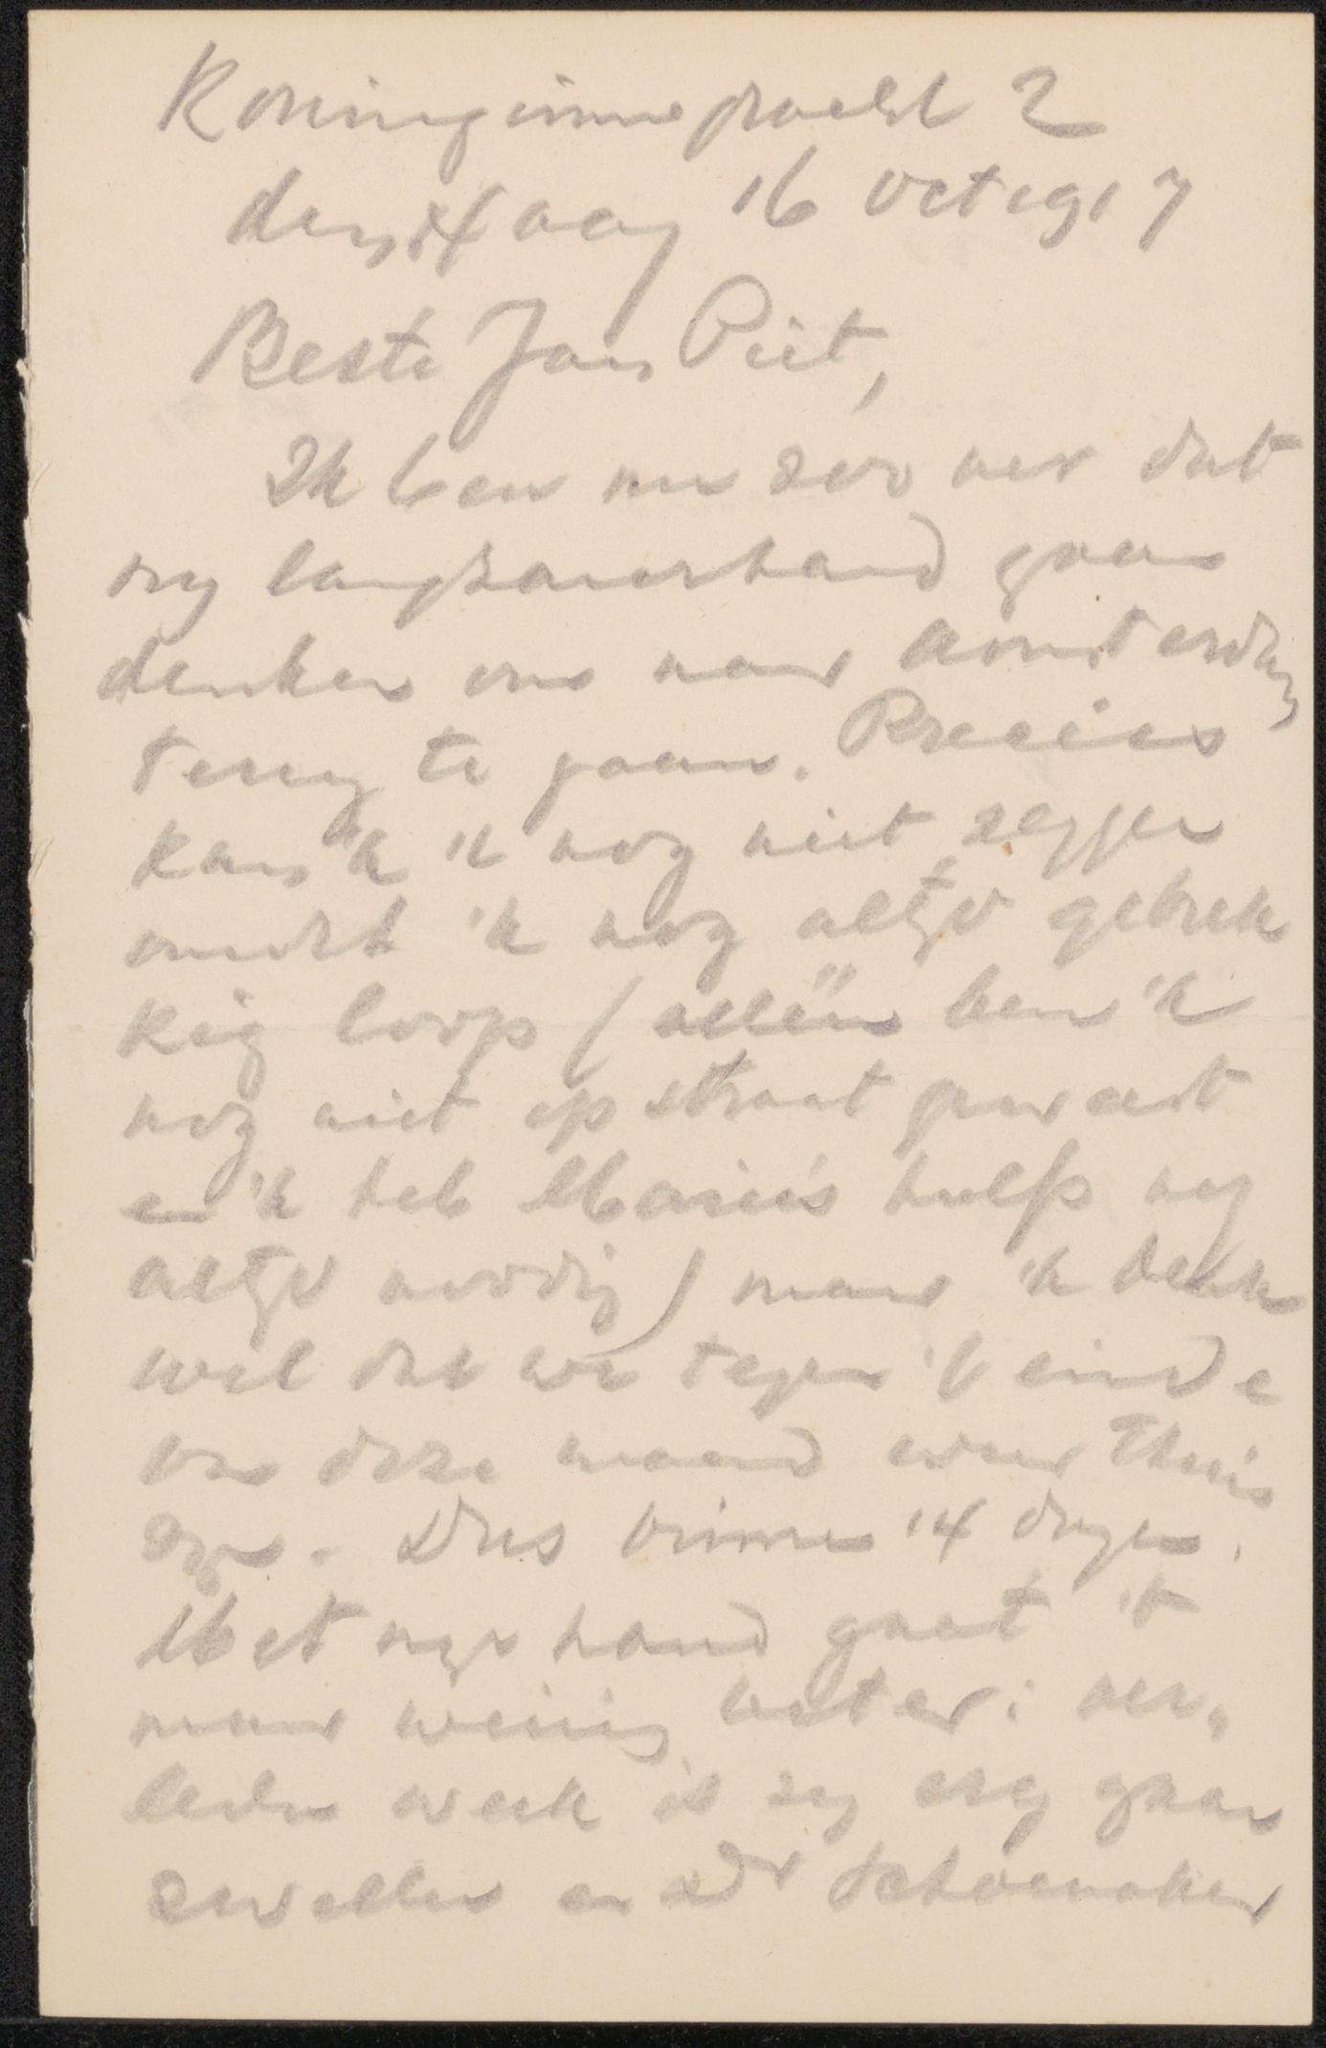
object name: letter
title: Brief aan Jan Veth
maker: willem witsen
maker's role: draughtsman, painter, print maker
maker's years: 1860-1923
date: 1917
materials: paper, pencil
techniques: writing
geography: the hague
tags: jan veth, amsterdam, painter, print maker, draughtsman, isaac israels, anonymous historical person portrayed, diseases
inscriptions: watermark, collector's mark: ‘RPK’